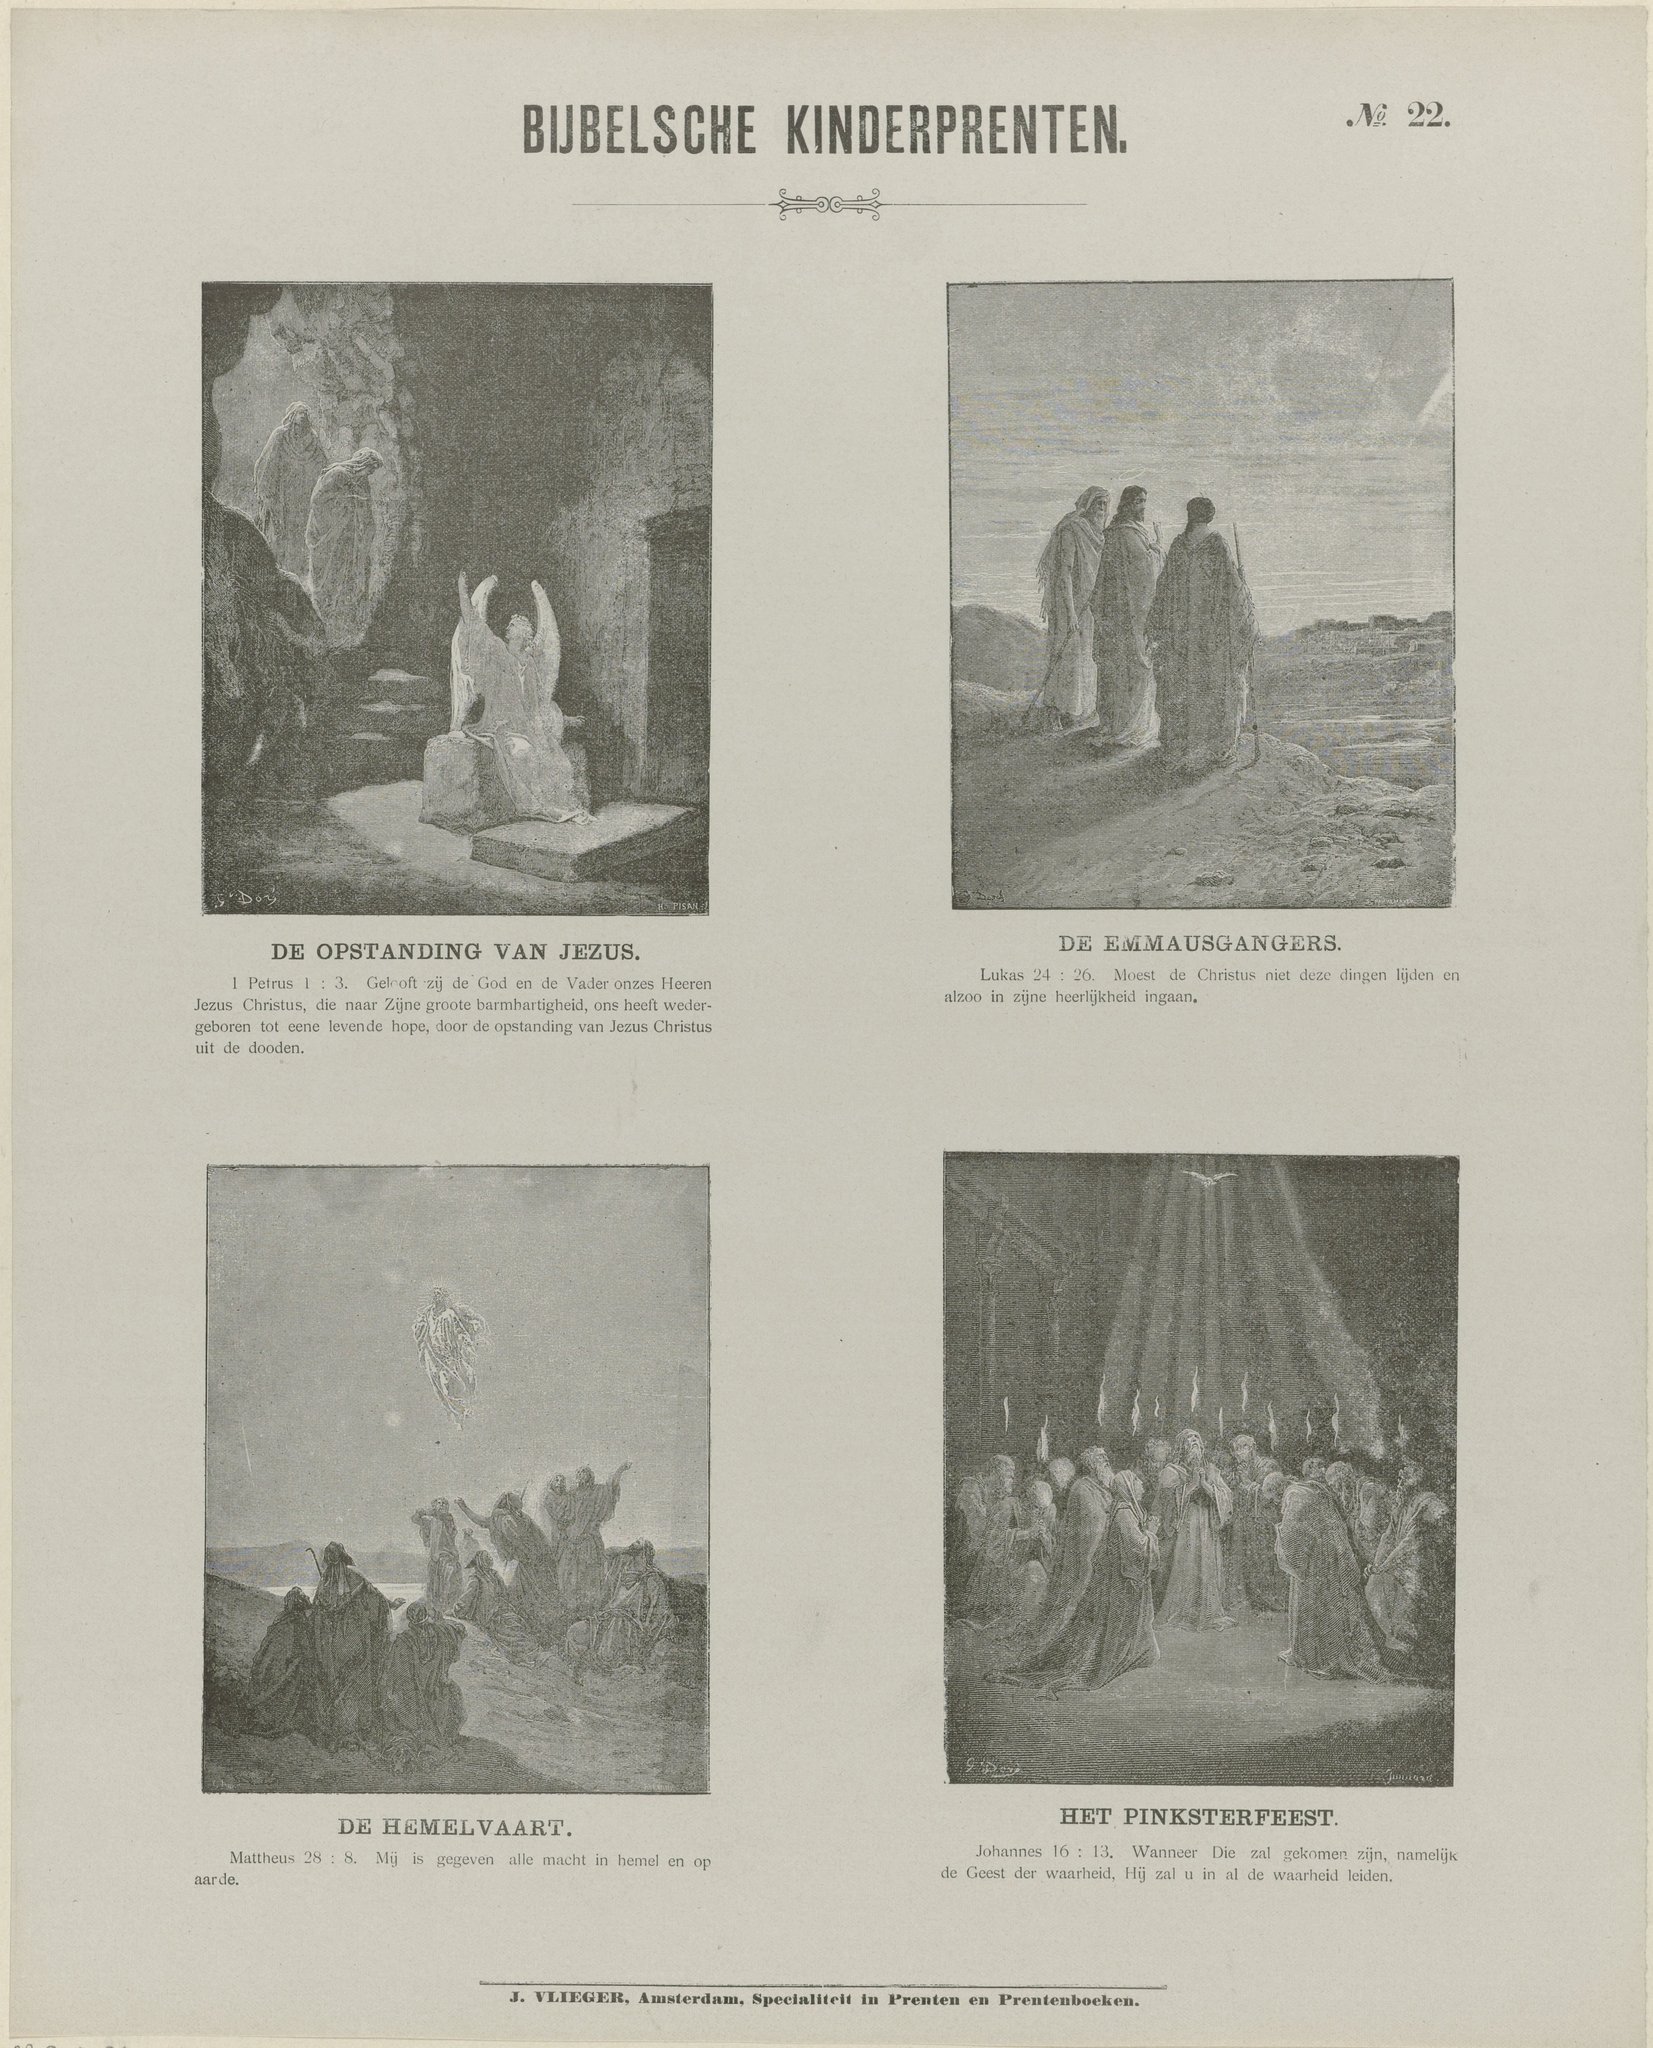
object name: popular print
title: Bijbelsche kinderprenten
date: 1869-1908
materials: paper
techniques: letterpress printing, photoaquatint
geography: amsterdam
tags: the holy women (the three maries) on their way to or at the tomb, to anoint christ's body, new testament, cleopas and peter meet christ (sometimes they are dressed as pilgrims), pentecost: the holy ghost descends upon (mary and) the apostles, sometimes paul and/or representatives of the nations present (acts 2:1-4), christ aloft in the sky ~ ascension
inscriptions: collector's mark: Lugt 2760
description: Blad met 4 voorstellingen van verhalen uit het Nieuwe Testament. Bij het graf van Christus verschijnt een engel aan de vrouwen die Christus komen zalven, Christus en de twee de Emmaüsgangers op een heuvel, de hemelvaart van Christus en de Heilige Geest daalt neer op Maria en de apostelen (Pinksteren). Onder elke afbeelding een Bijbeltekst. Genummerd rechtsboven: No. 22.